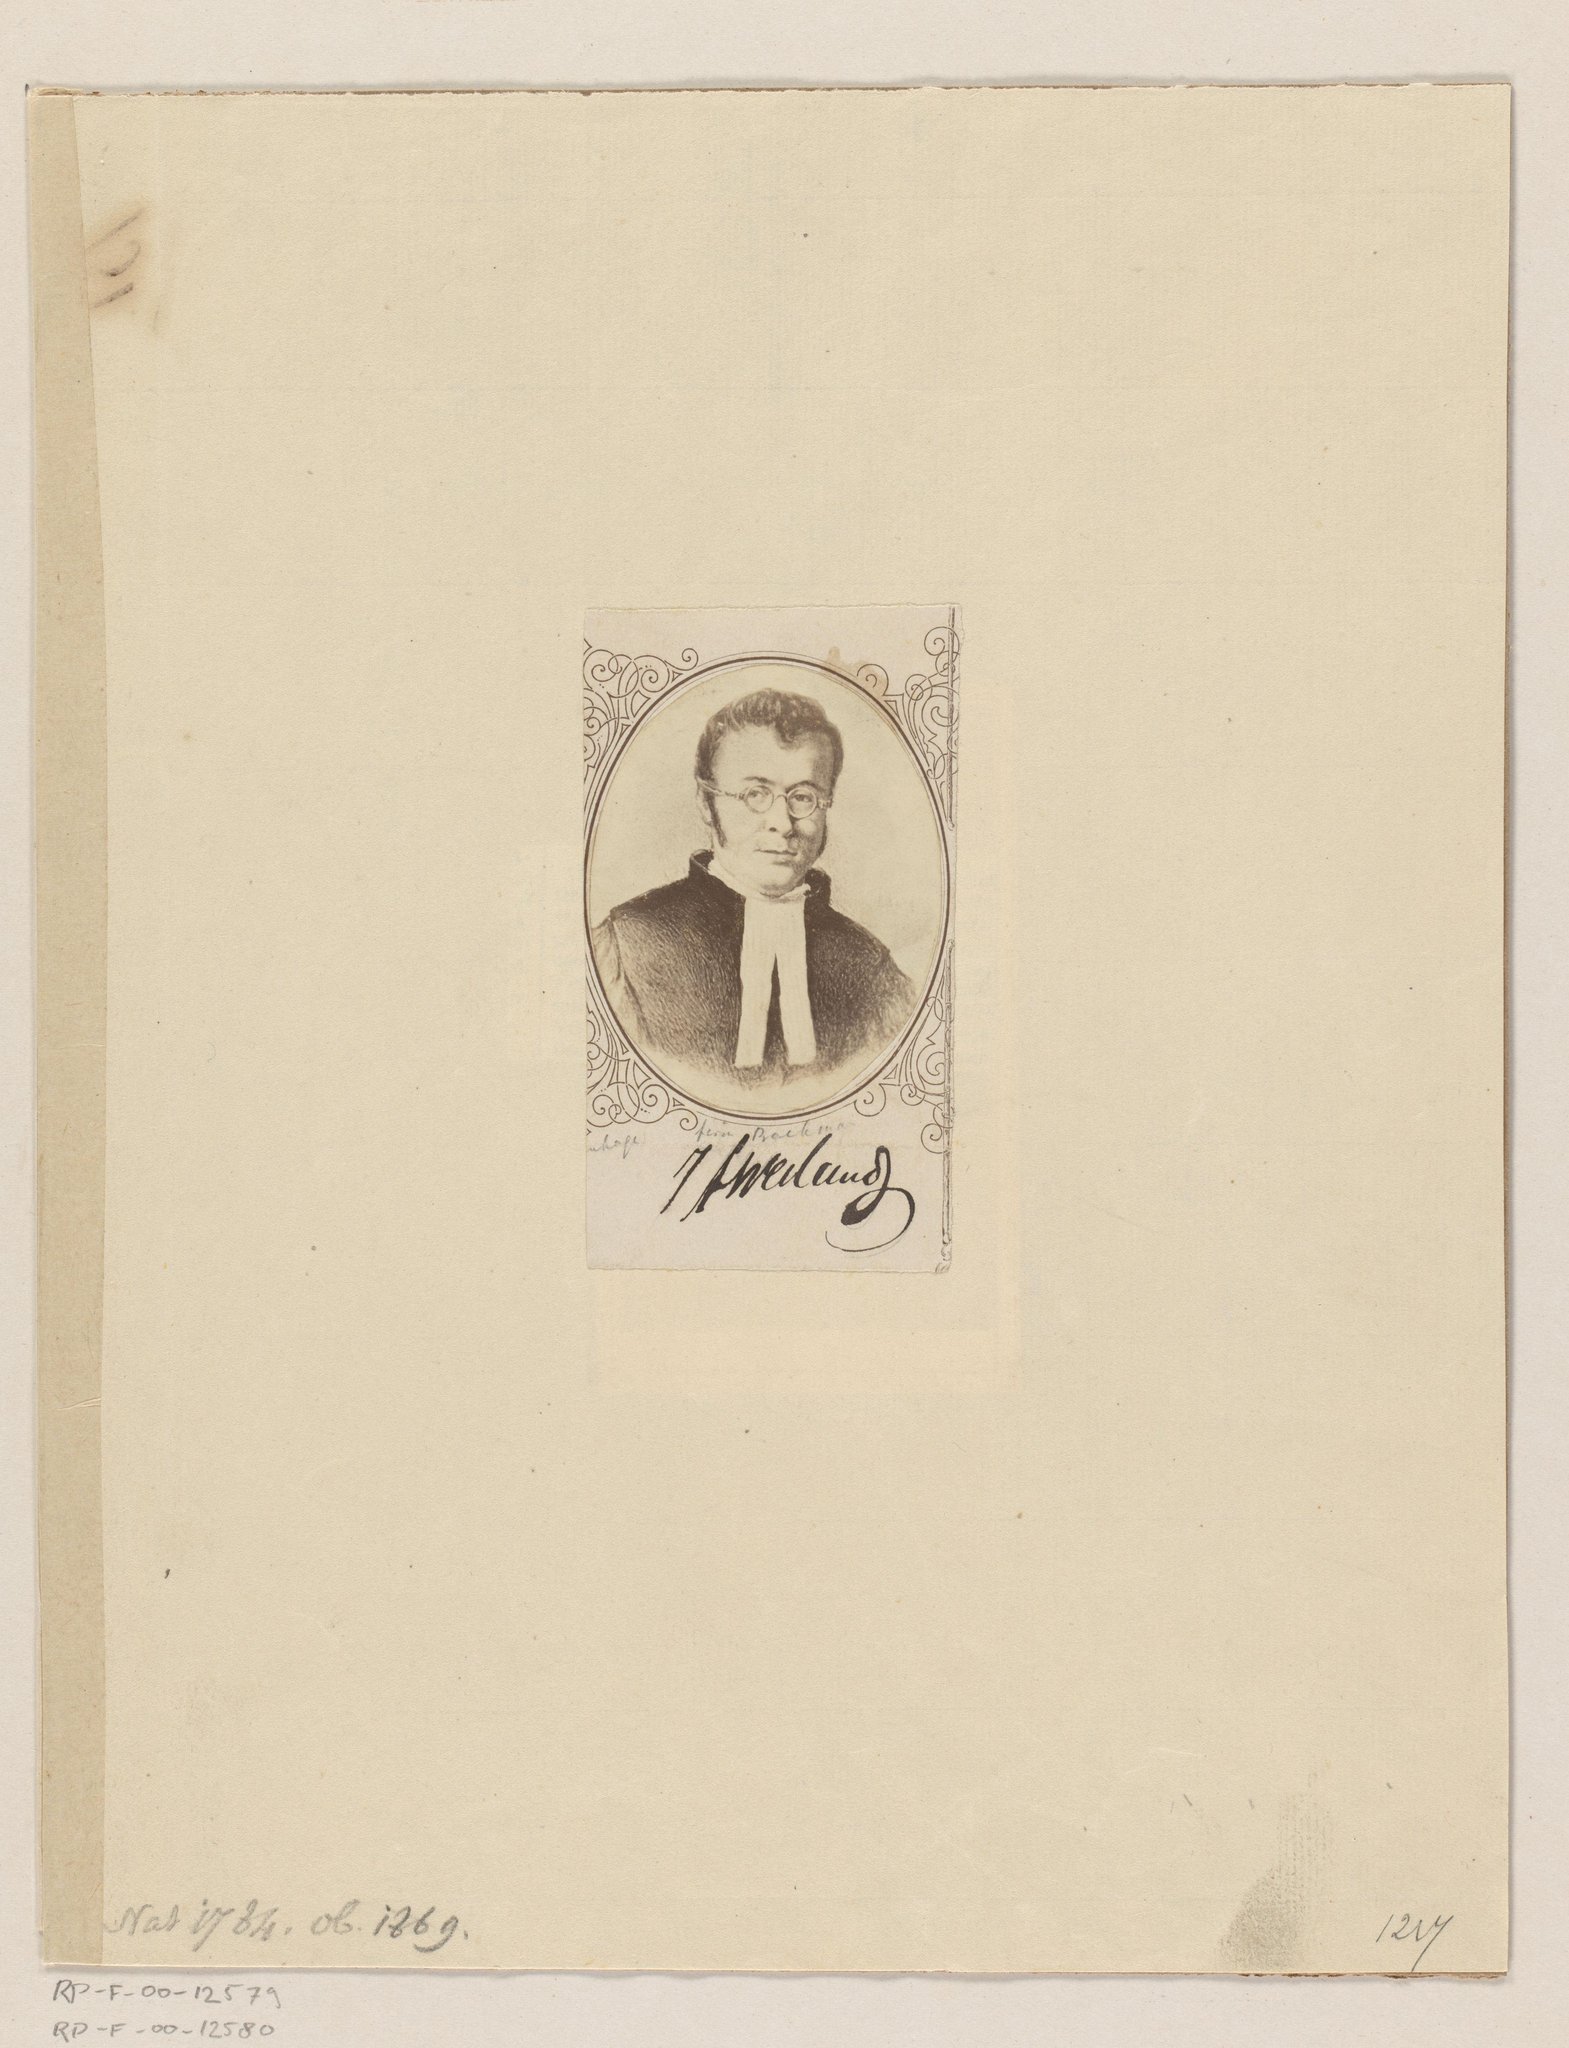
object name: photograph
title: Fotoreproductie van een getekend portret van Jacobus Adrianus Weiland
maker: Anonymous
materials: cardboard, paper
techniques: albumen print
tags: utrecht, the hague, print maker, jacobus adrianus weiland, historical persons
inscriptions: inscription: ‘Heden overleed na een langdurig en smartelijk/ lijden, in den ouderdom van 82 jaren, mijn geliefde/ Echtgenoot JACOBUS ANDRIES WEILAND,/ oud Raadsheer in het Provinciaal Geregtshof van/ Zuid-Holland./ Weduwe J. A. WEILAND,/ Geboren J. Buiks./ 's Gravenhage, 8 Mei 1896. [4255]’, number: ‘131.’